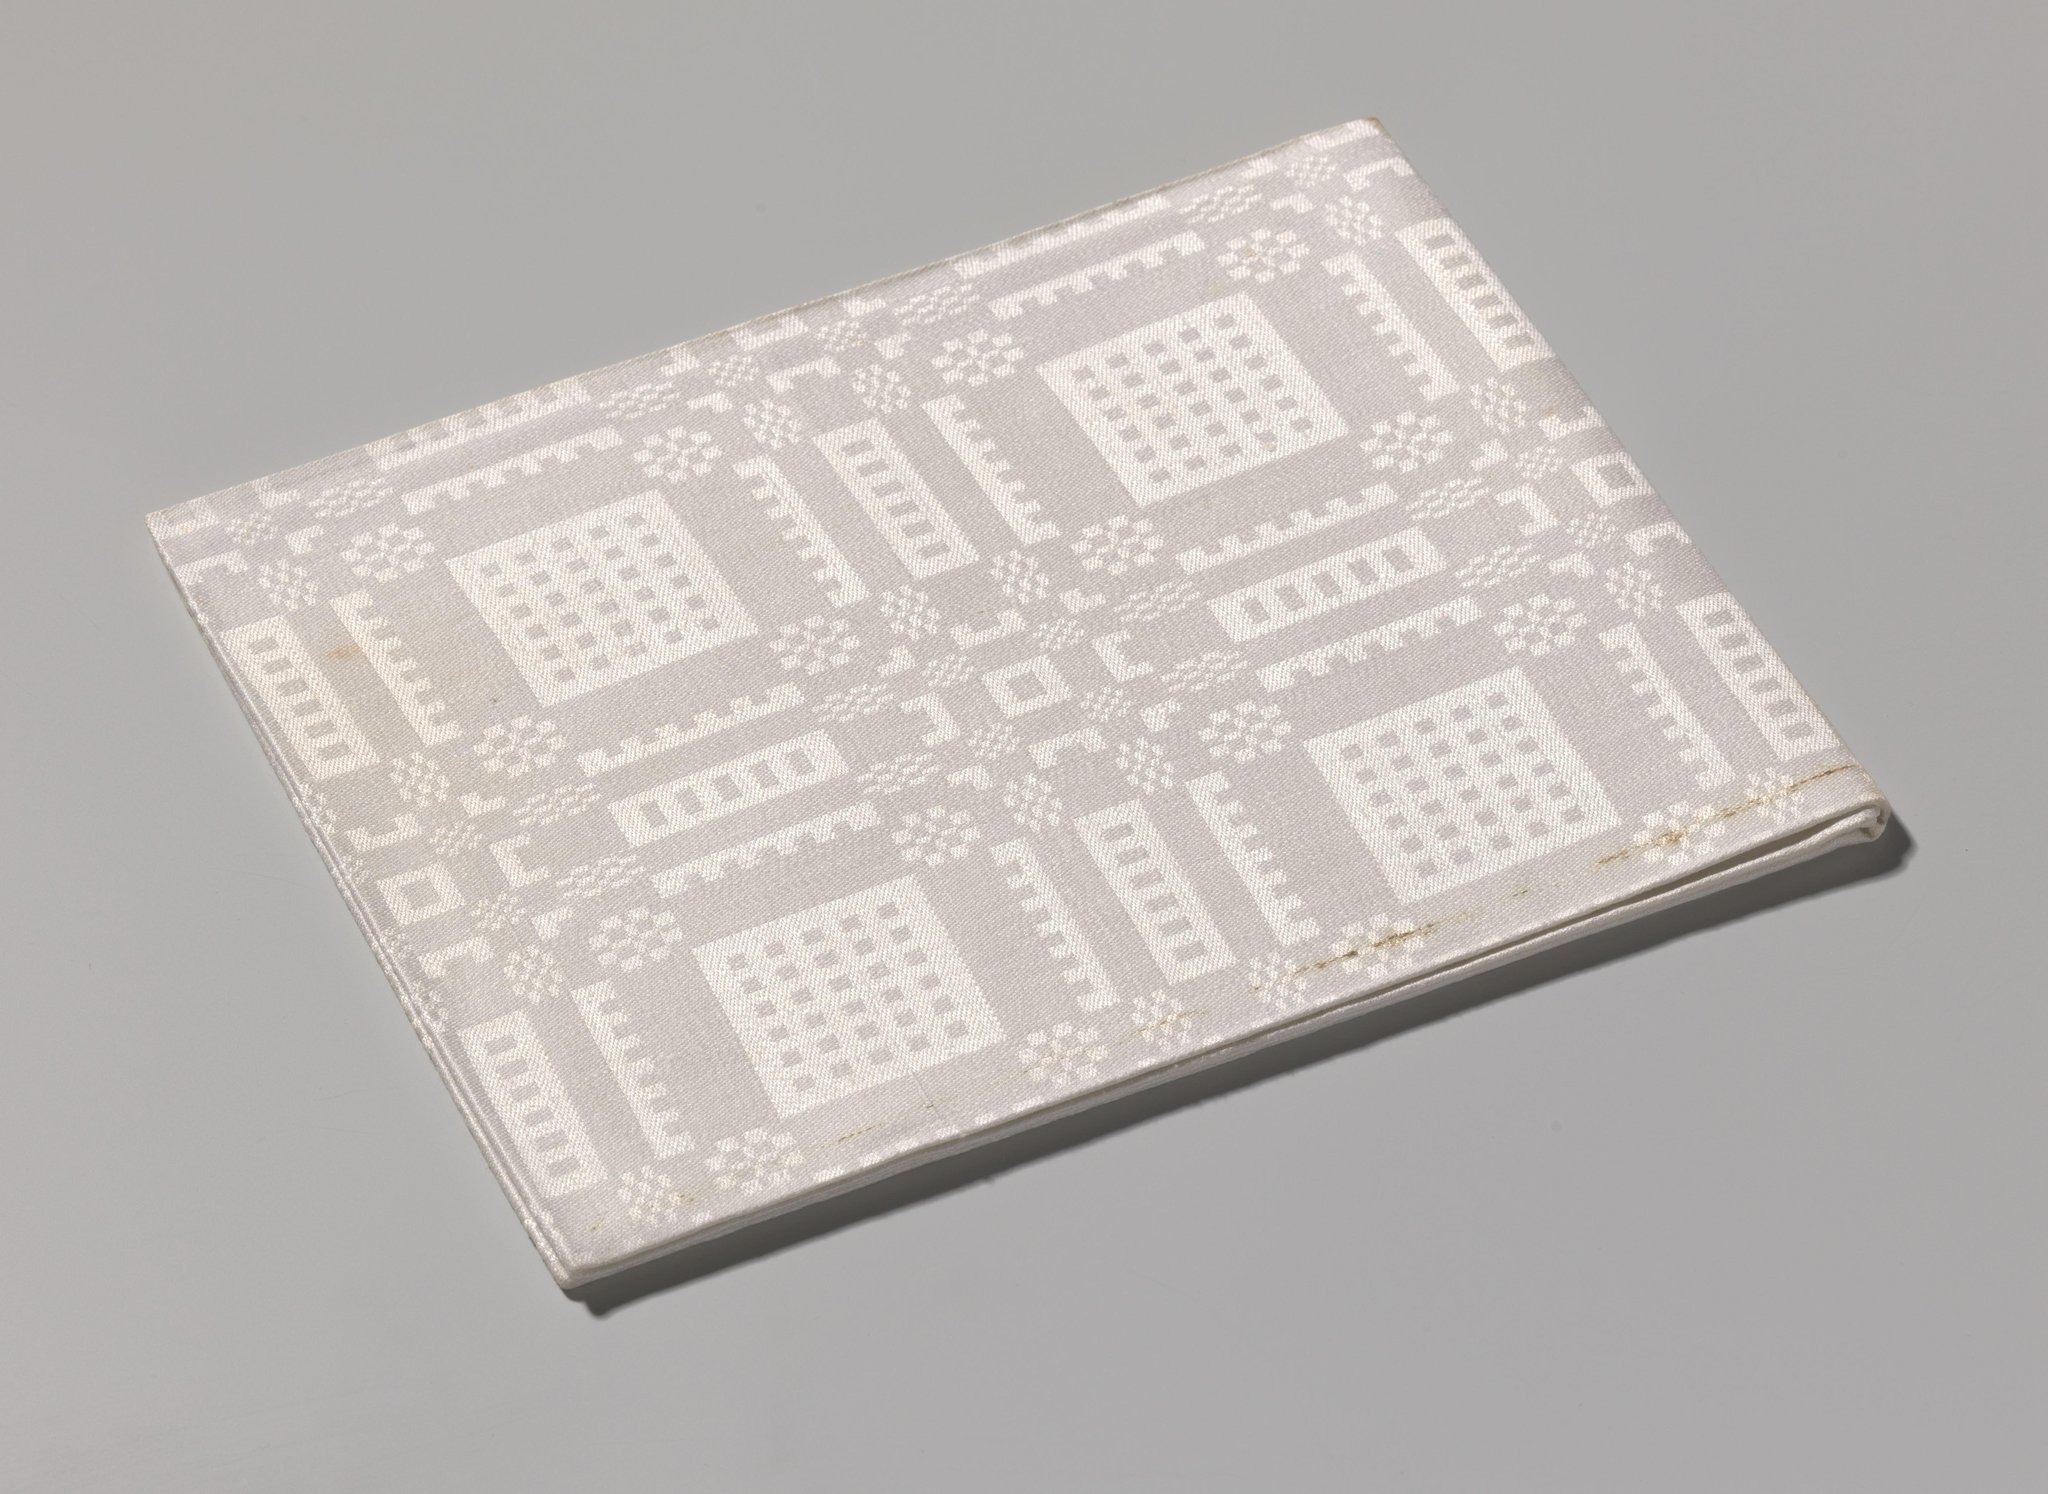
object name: napkin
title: Servet met pellenpatroon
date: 1756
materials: linen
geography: northern netherlands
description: Servet van wit linnen met pellenpatroon, merk kroon G 30 en 1756.